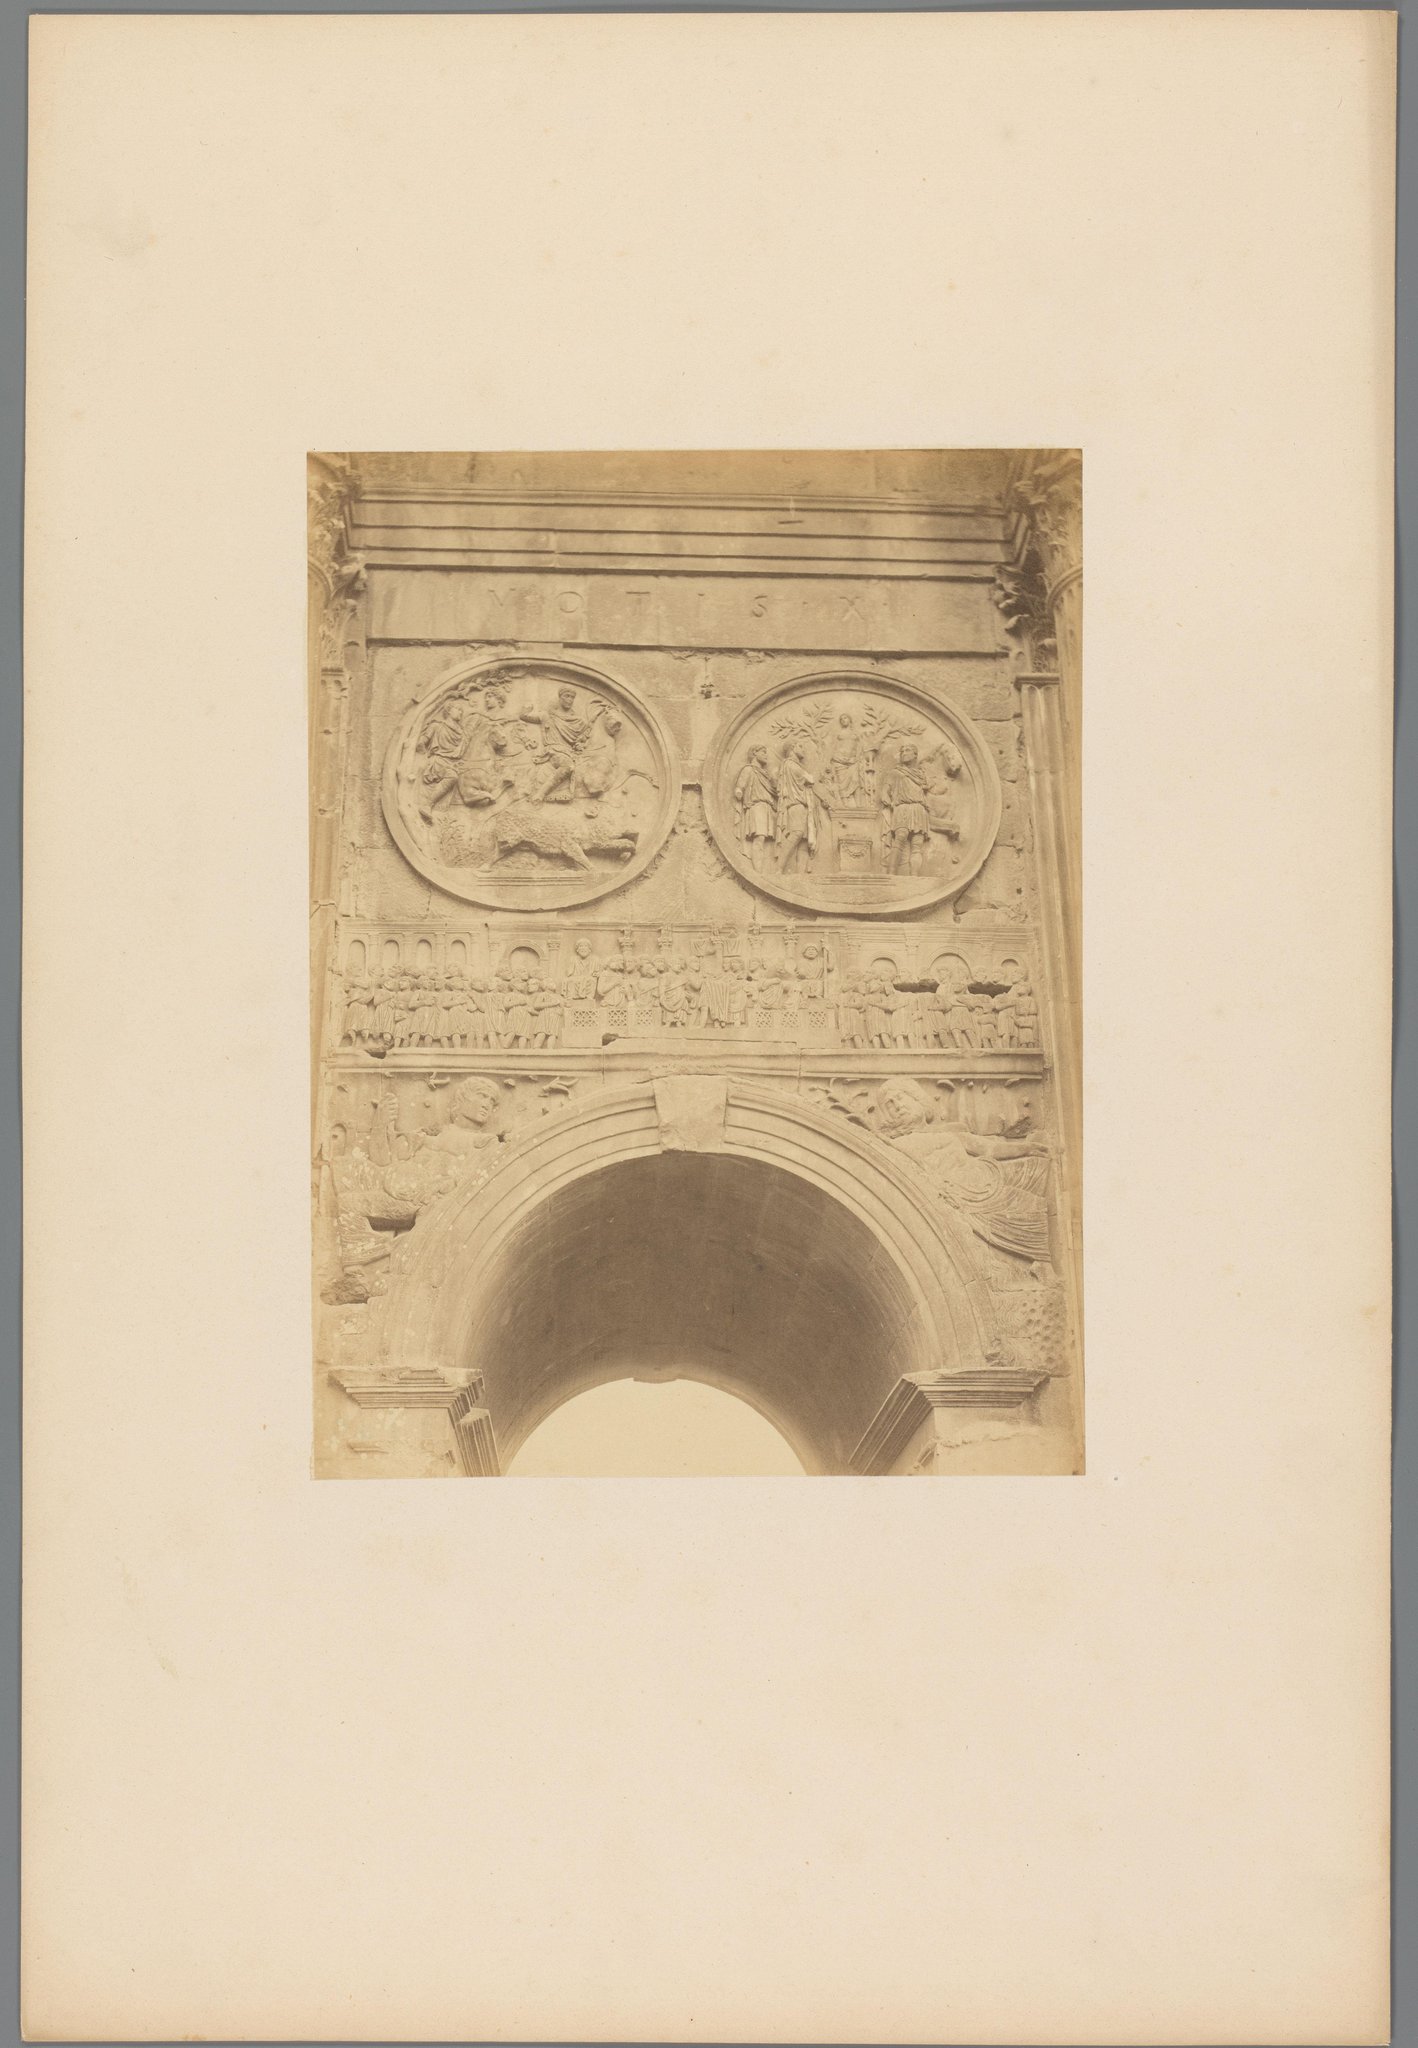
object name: photograph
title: Detail van de Boog van Constantijn te Rome, Italië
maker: Anonymous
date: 1851-1900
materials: cardboard, paper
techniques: albumen print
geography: rome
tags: triumphal arch, arch of constantine